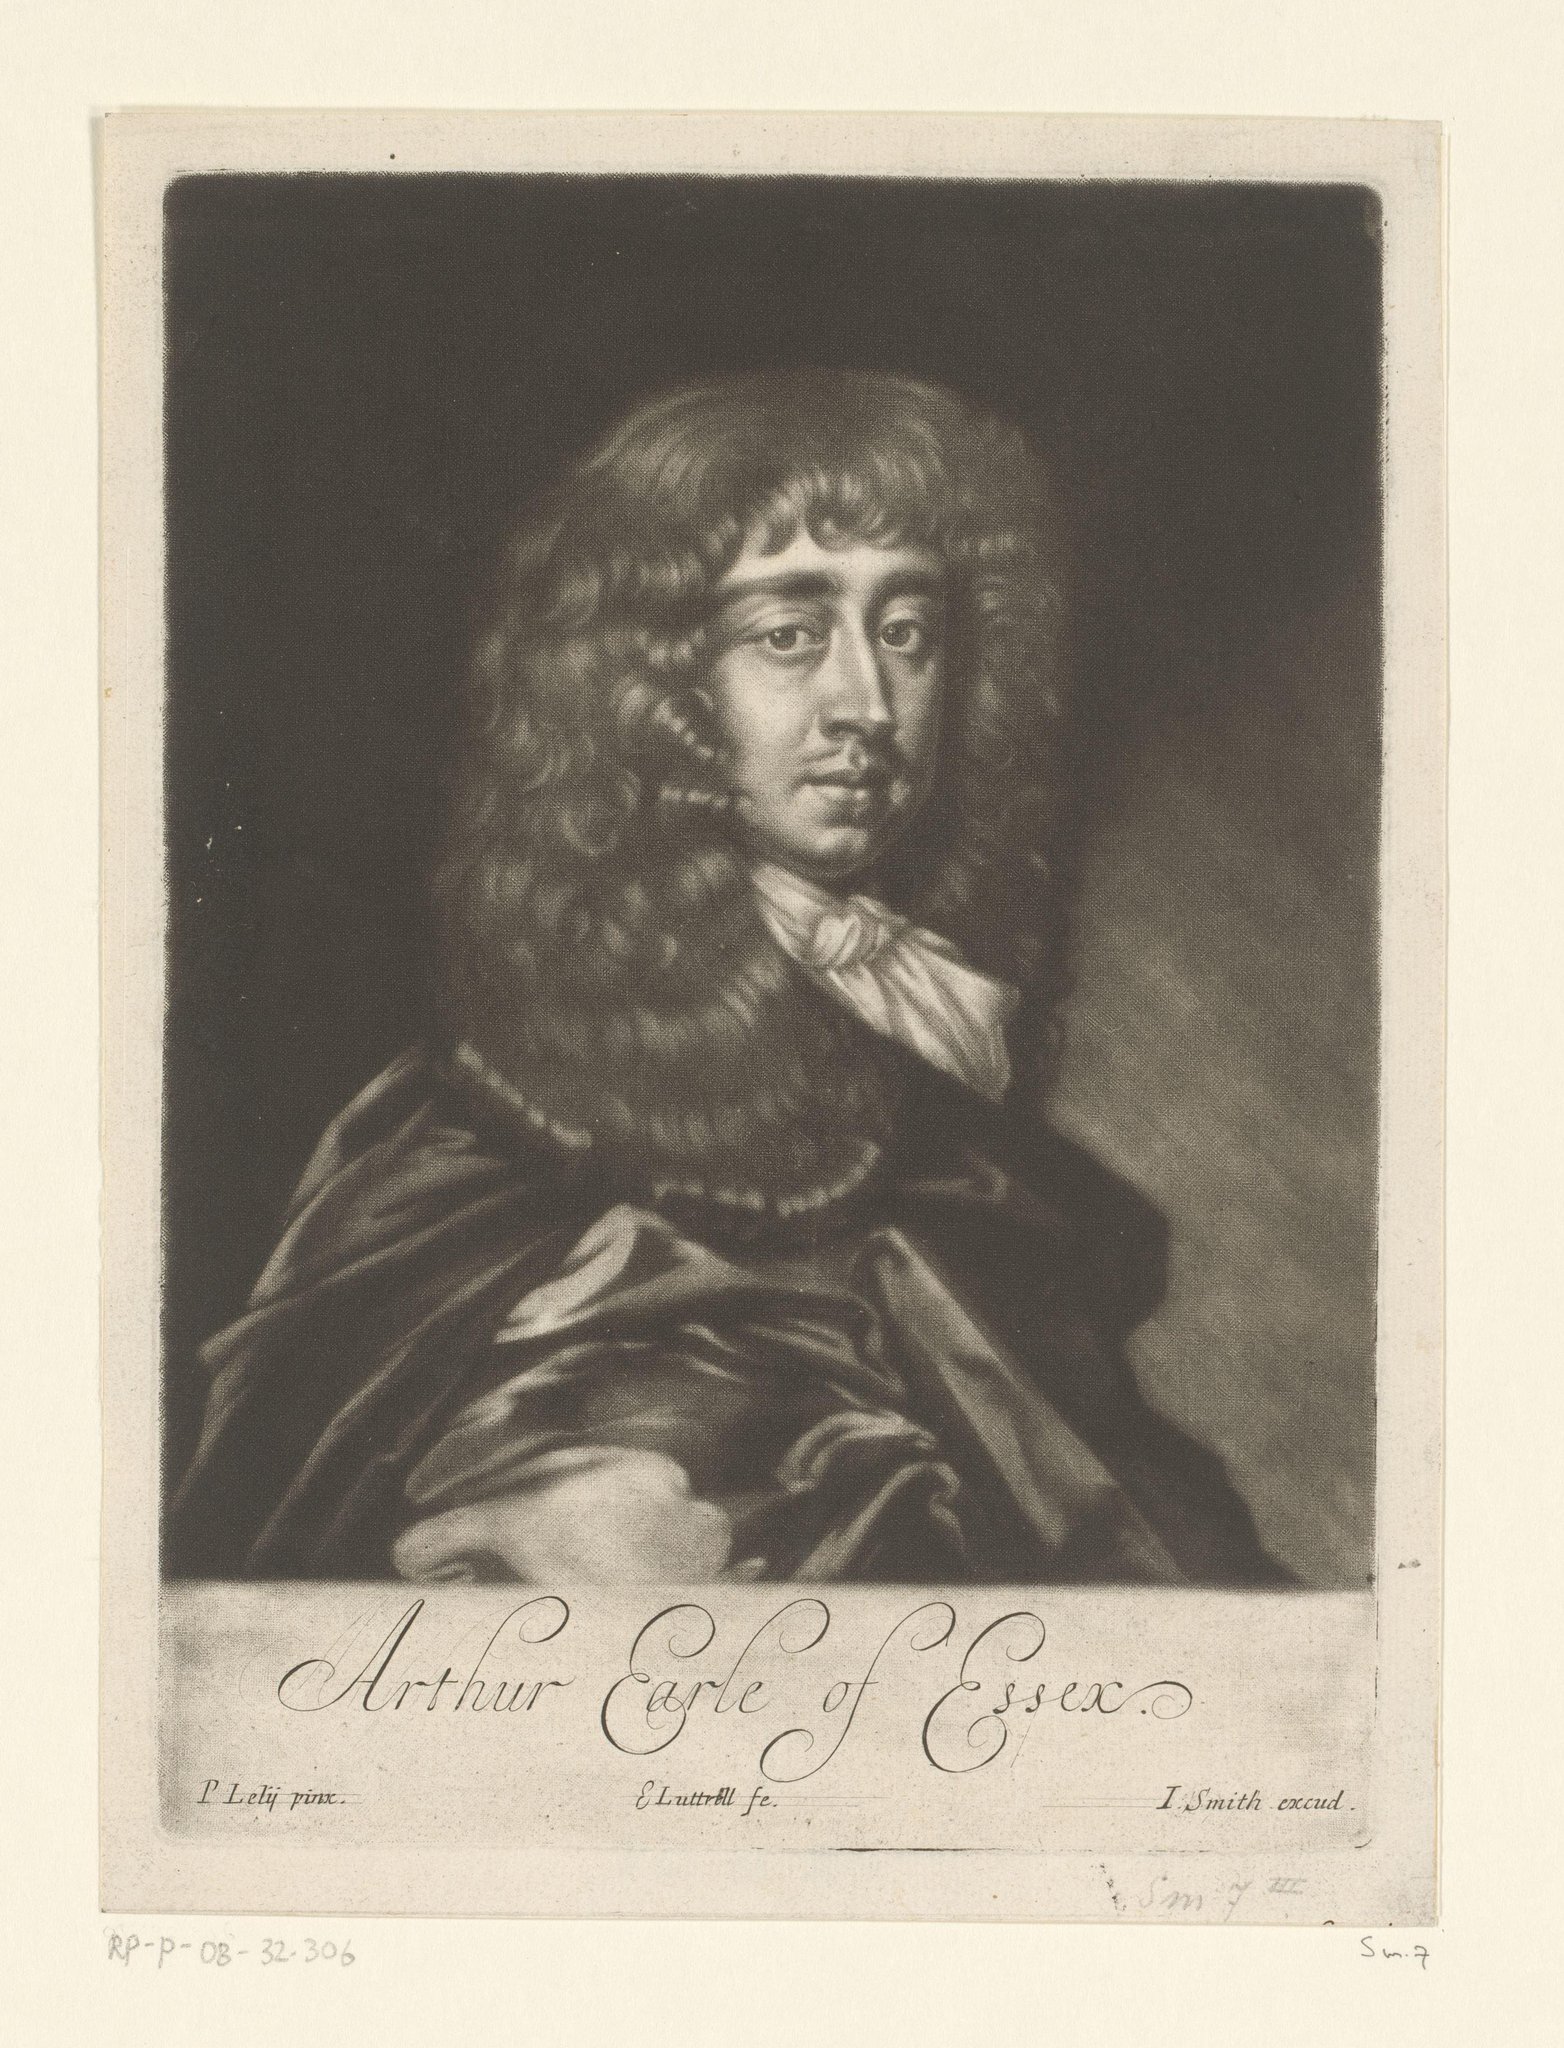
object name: print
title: Arthur Earle of Essex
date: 1660-1742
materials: paper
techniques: etching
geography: london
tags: historical persons, politician, e.g. party leader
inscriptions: collector's mark: Lugt 240